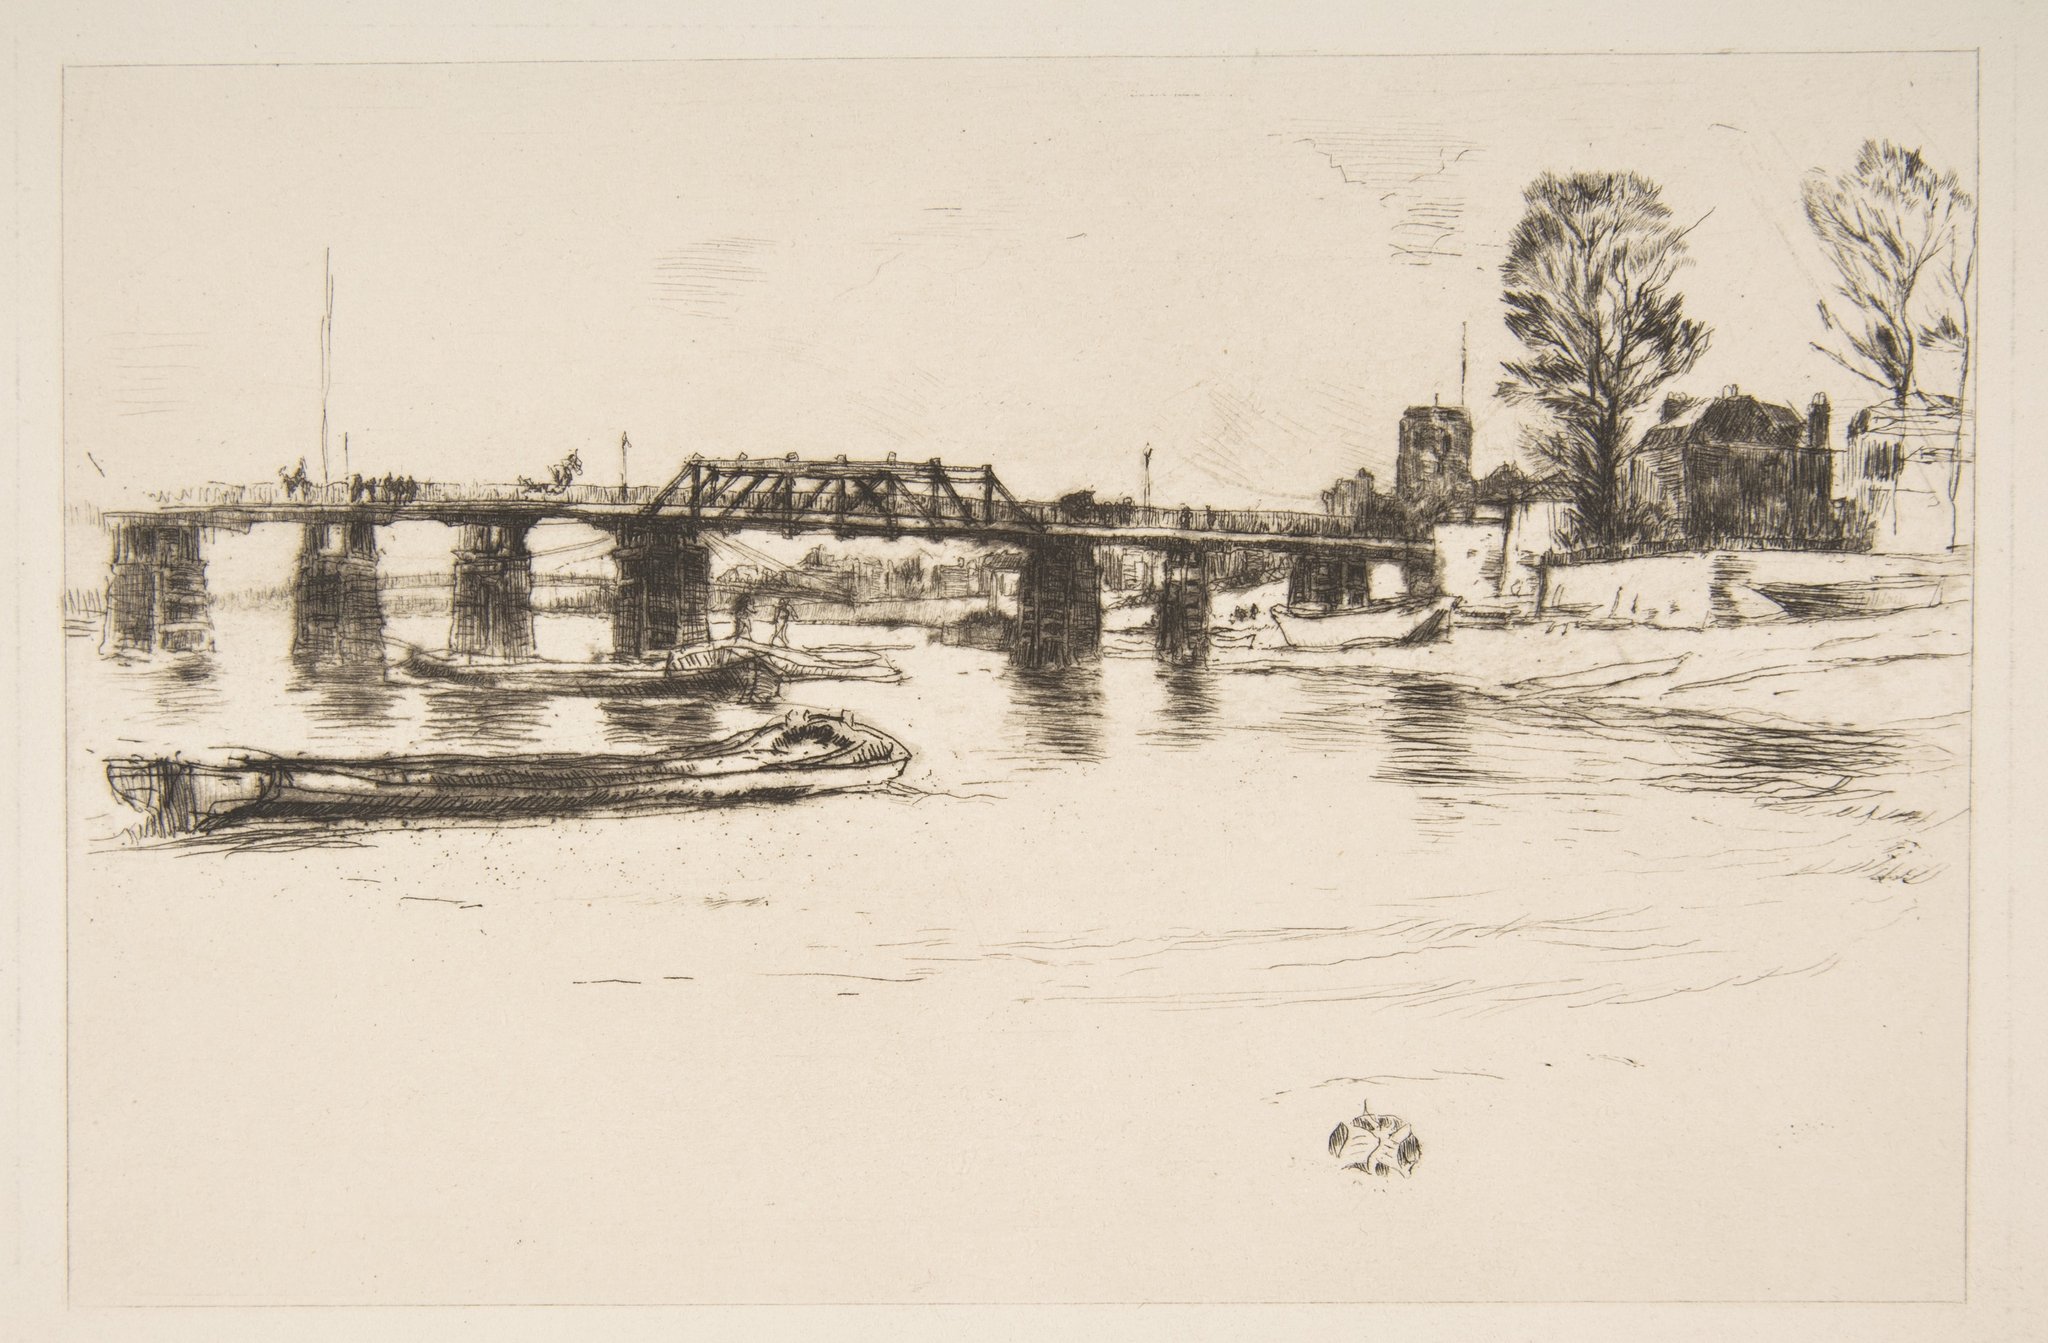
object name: print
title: Fulham (Chelsea)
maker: james mcneill whistler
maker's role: artist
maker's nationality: american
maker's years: 1834-1903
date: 1901-2000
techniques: etching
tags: bridges,rivers,boats